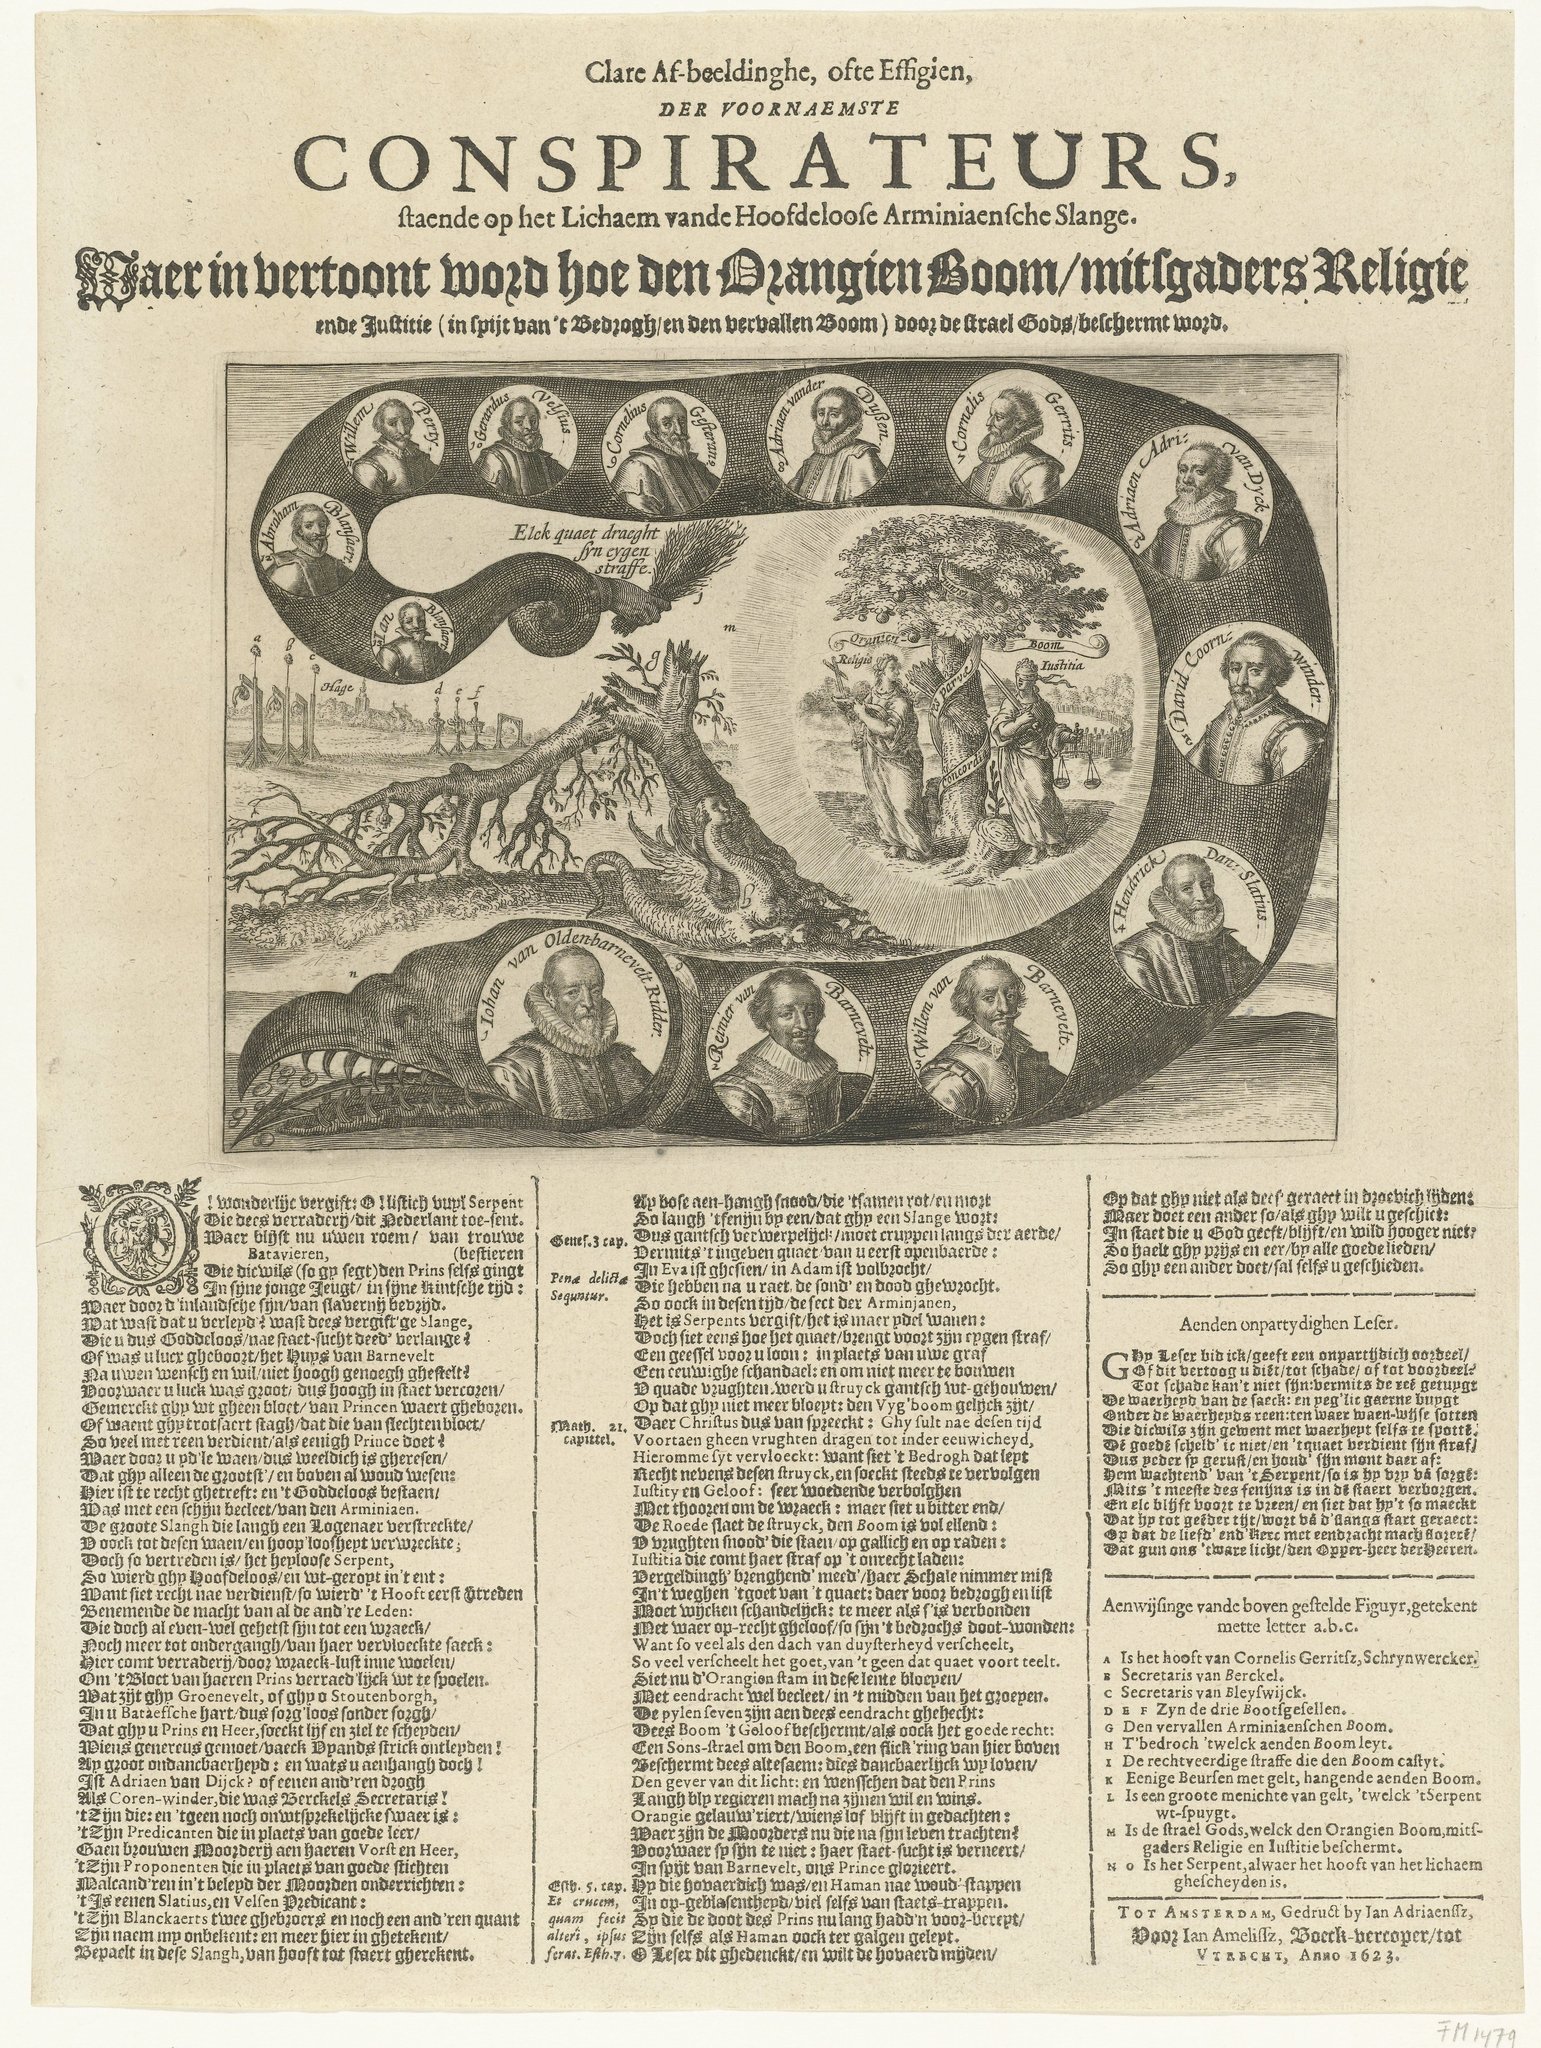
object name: print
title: Arminiaanse slang met de samenzweerders tegen Maurits, 1623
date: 1623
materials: paper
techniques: engraving, etching, letterpress printing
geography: amsterdam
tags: johan van oldenbarnevelt, maurice (prince of orange), brussels, bruges, assendelft, hoorn (north holland), the hague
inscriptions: date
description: De Arminiaanse slang met de portretten van Johan van Oldenbarnevelt en de in 1623 gearresteerde samenzweerders tegen Maurits. In het midden de gebroken Arminiaanse boom en de bloeiende Oranjeboom beschermd door de personificaties van Religie en Rechtvaardigheid en het stralende licht Gods. In de staart van de slang een roede. Gedrukt onder de voorstelling tekst en legenda A-O in 3 kolommen in het Nederlands.